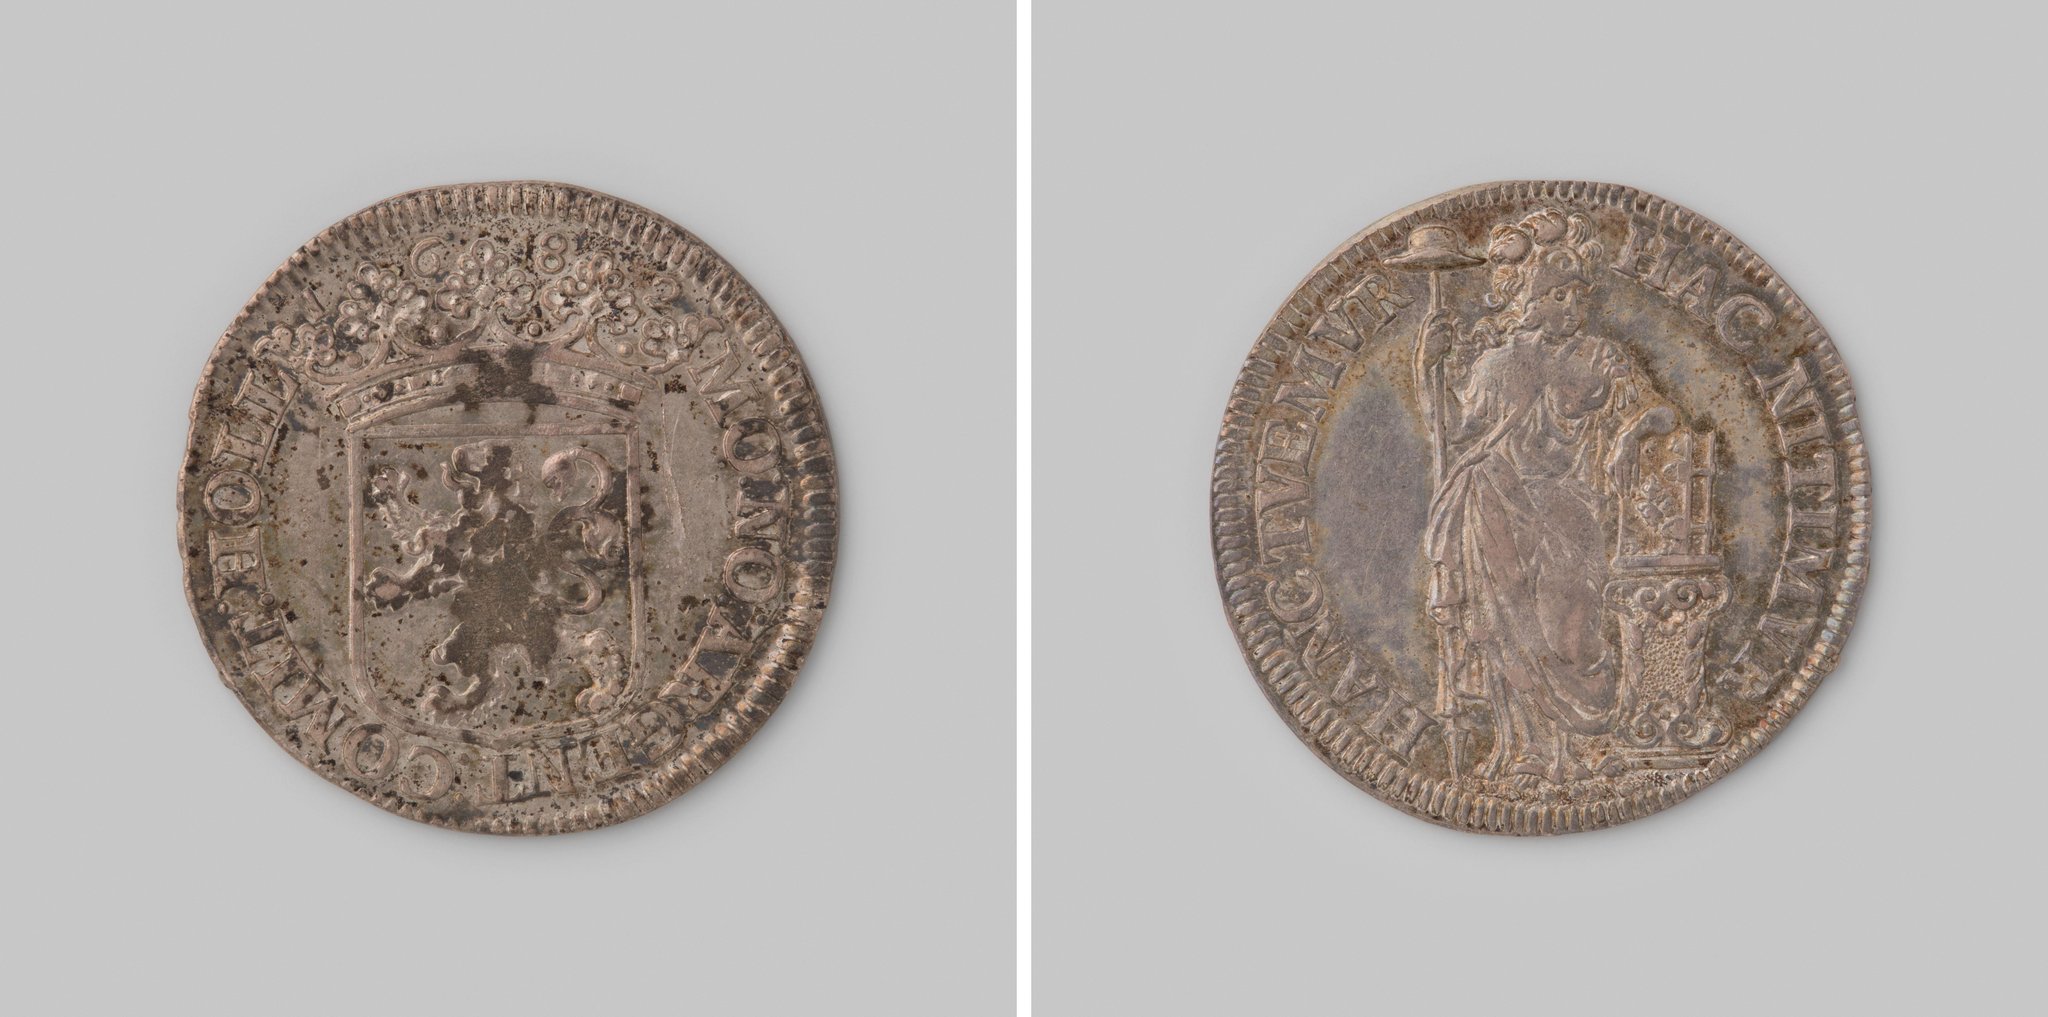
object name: coin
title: Hollandse provinciale halve gulden, 1682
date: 1682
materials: silver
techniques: striking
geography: dordrecht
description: Zilveren munt. Voorzijde: gekroond wapenschild van Holland. Boven kroon jaartal. Keerzijde: staande Nederlandse maagd met in rechterhand speer, waarop hoed en met linkerhand steunend op altaar, waarop bijlbel.